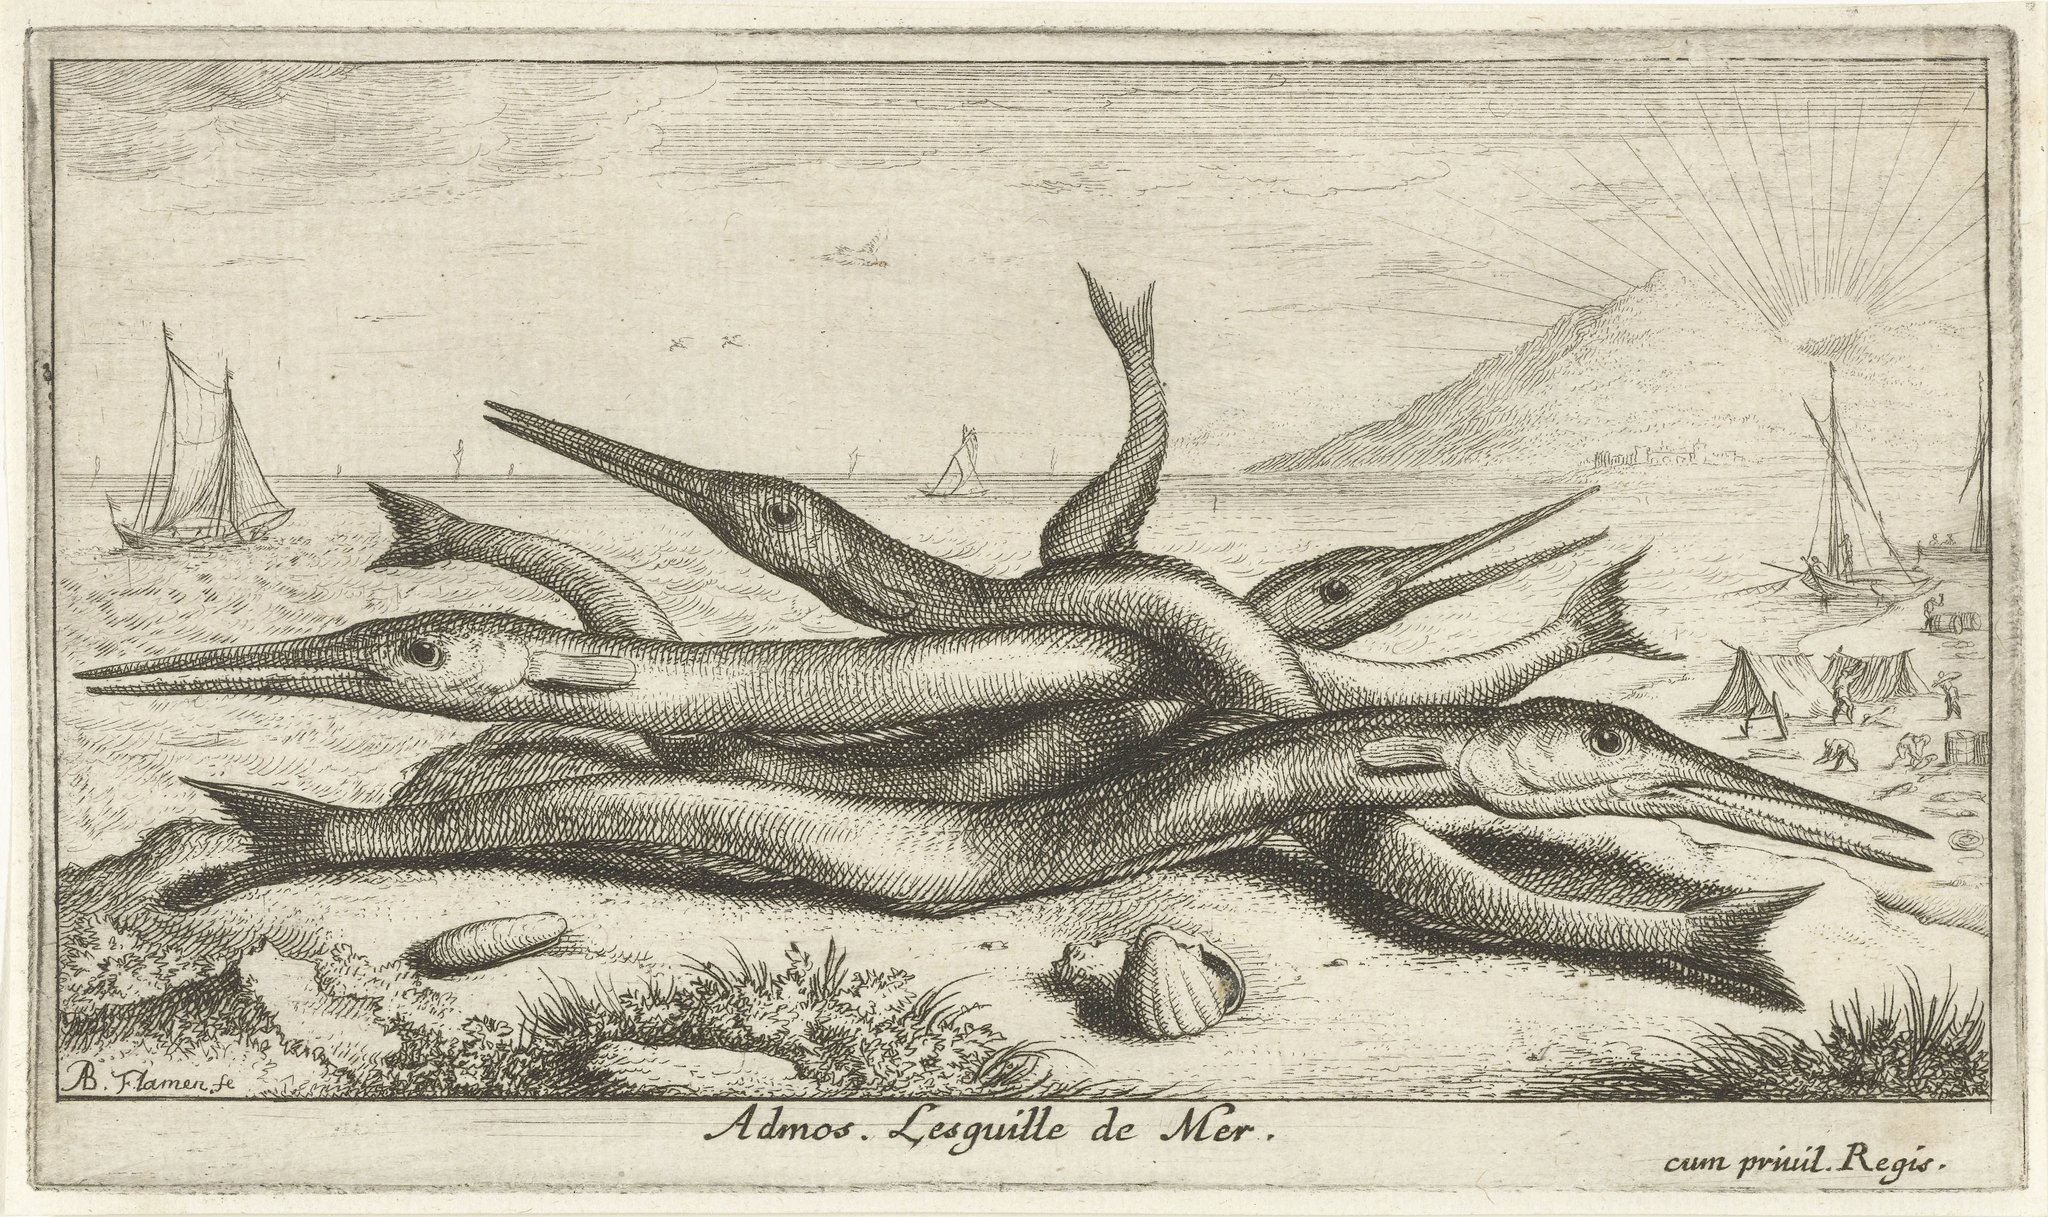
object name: print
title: Gepen op het strand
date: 1664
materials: paper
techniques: etching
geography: paris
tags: fishes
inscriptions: collector's mark: Lugt 2228